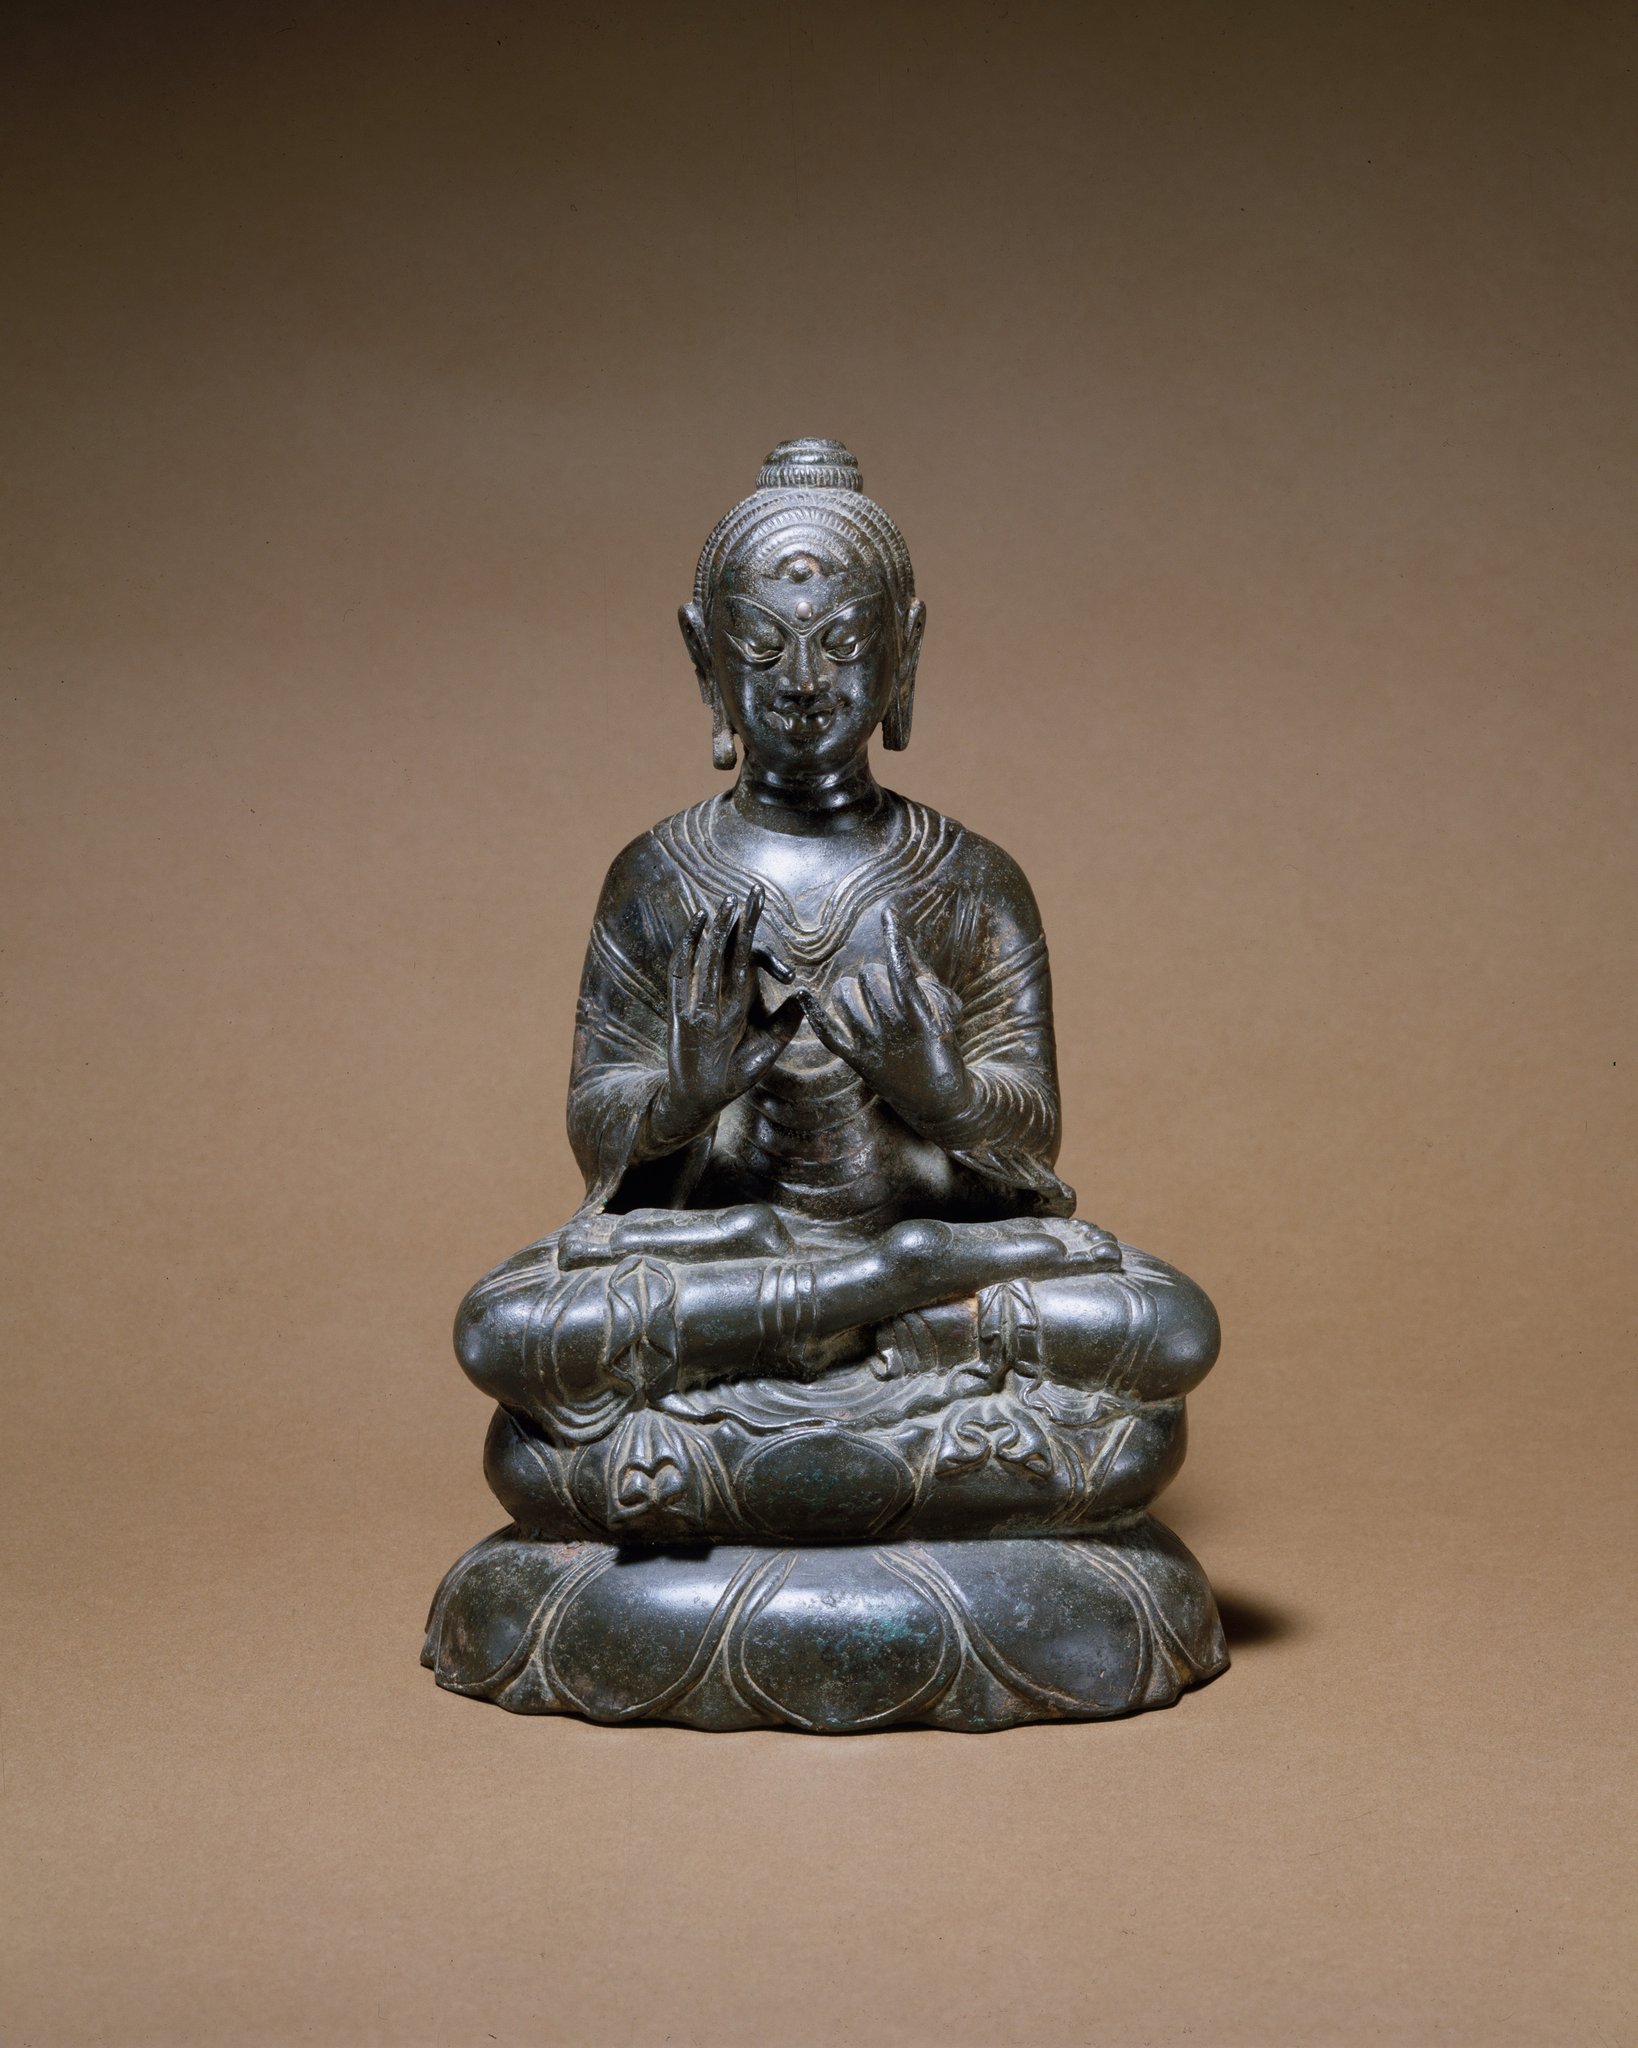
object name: figure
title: Preaching Buddha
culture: india, jammu & kashmir or pakistan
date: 701-800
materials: bronze, silver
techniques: inlay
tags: swat valley,buddhism,buddha